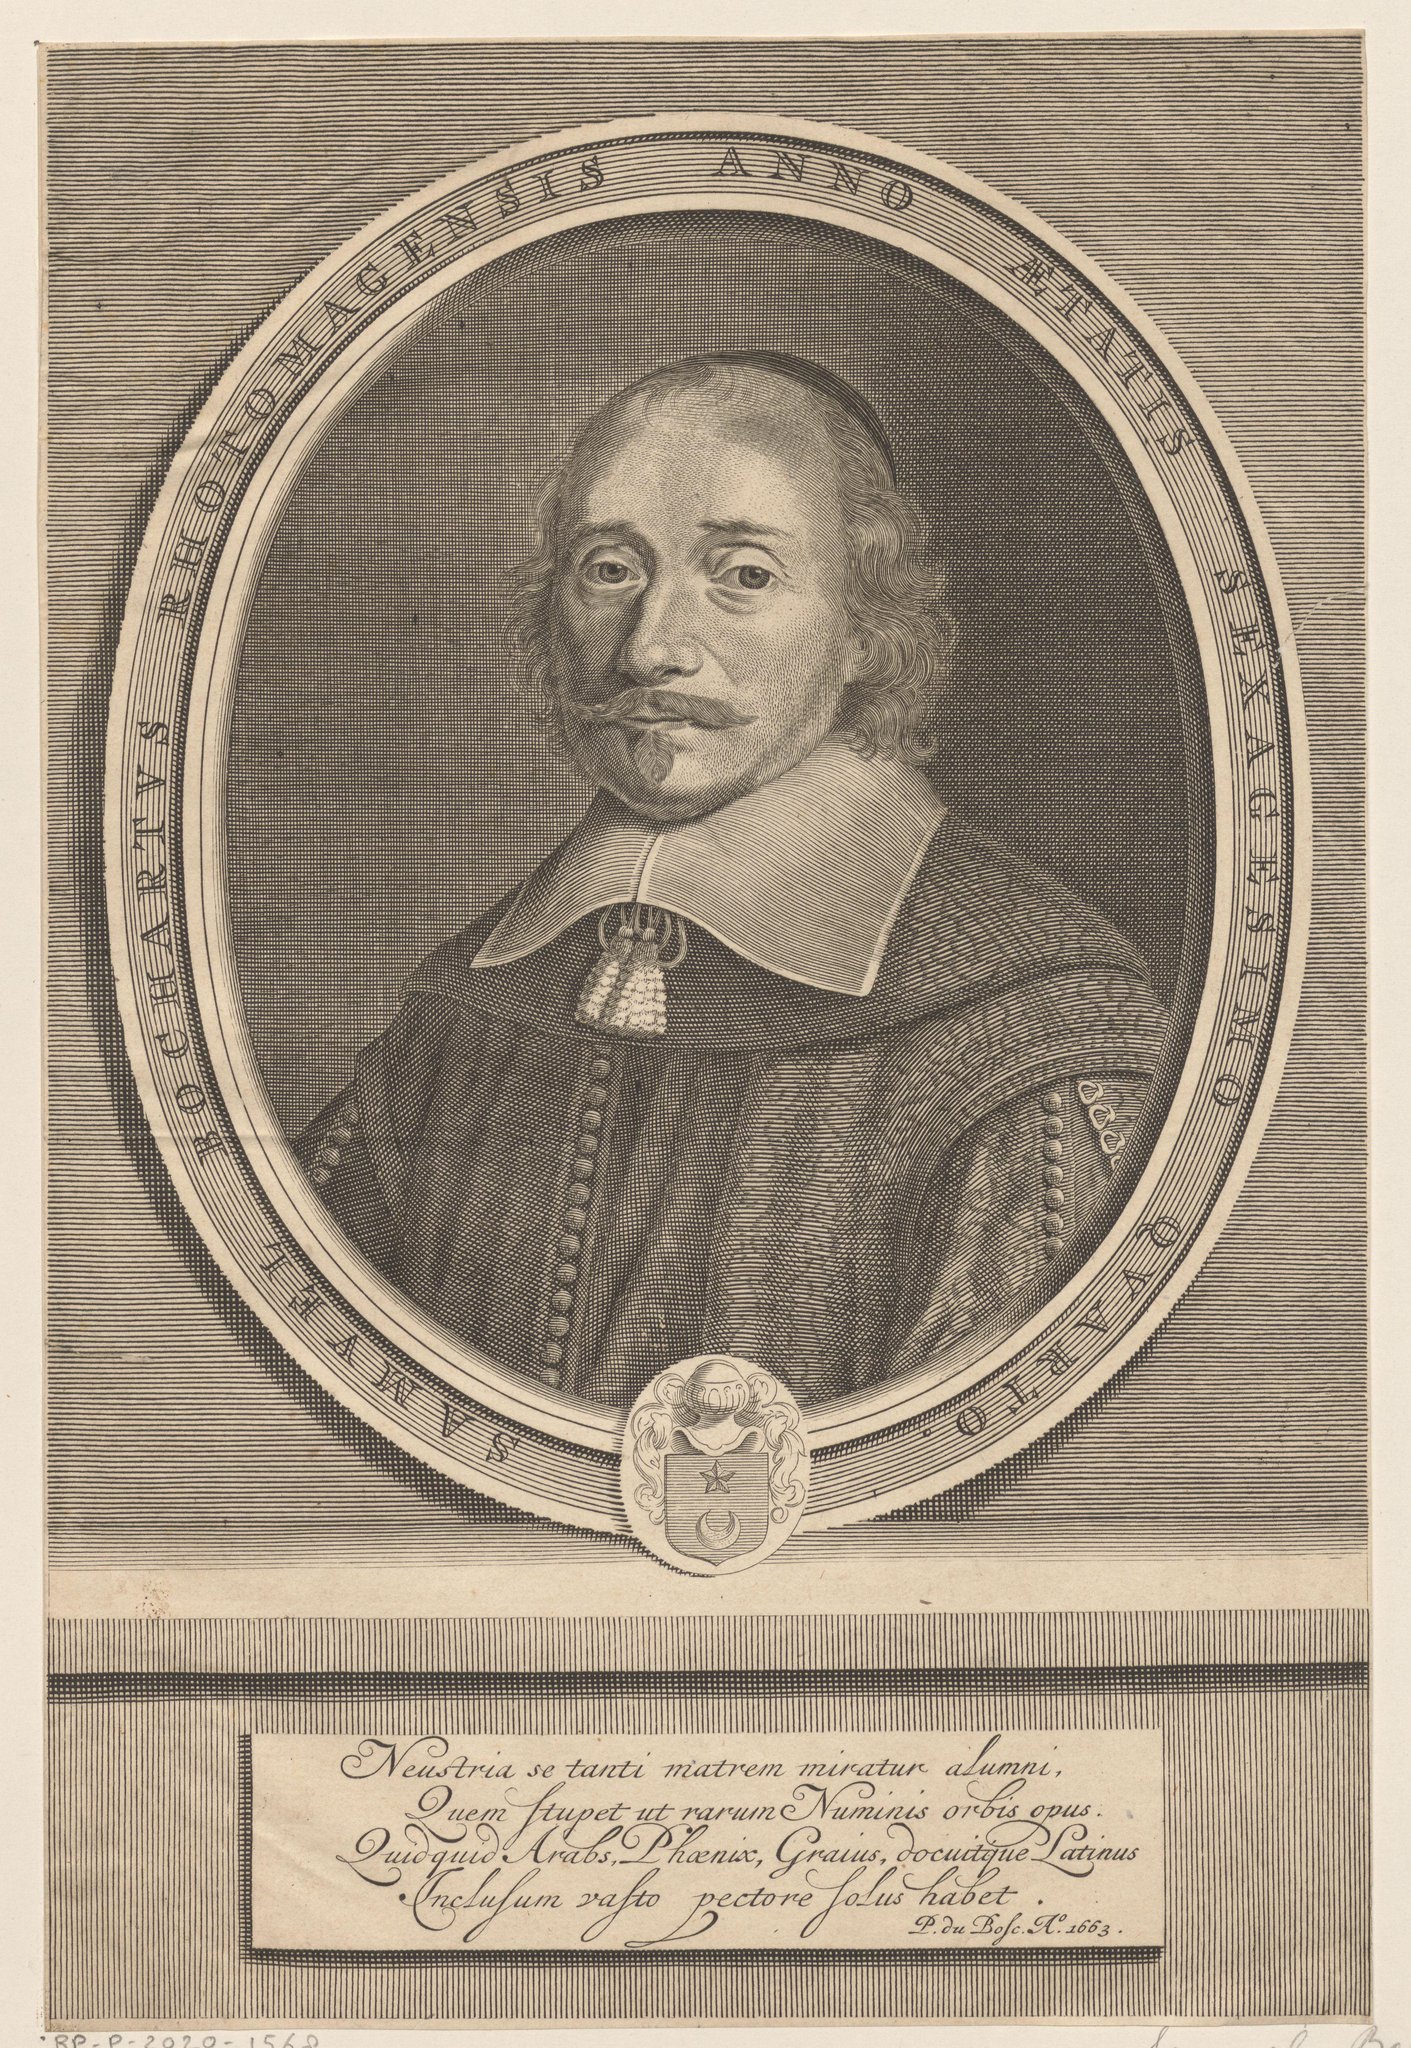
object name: print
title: Portret van Samuel Bochart op 64-jarige leeftijd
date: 1663-1699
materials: paper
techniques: engraving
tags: scholar, philosopher, historical persons, armorial bearing, heraldry